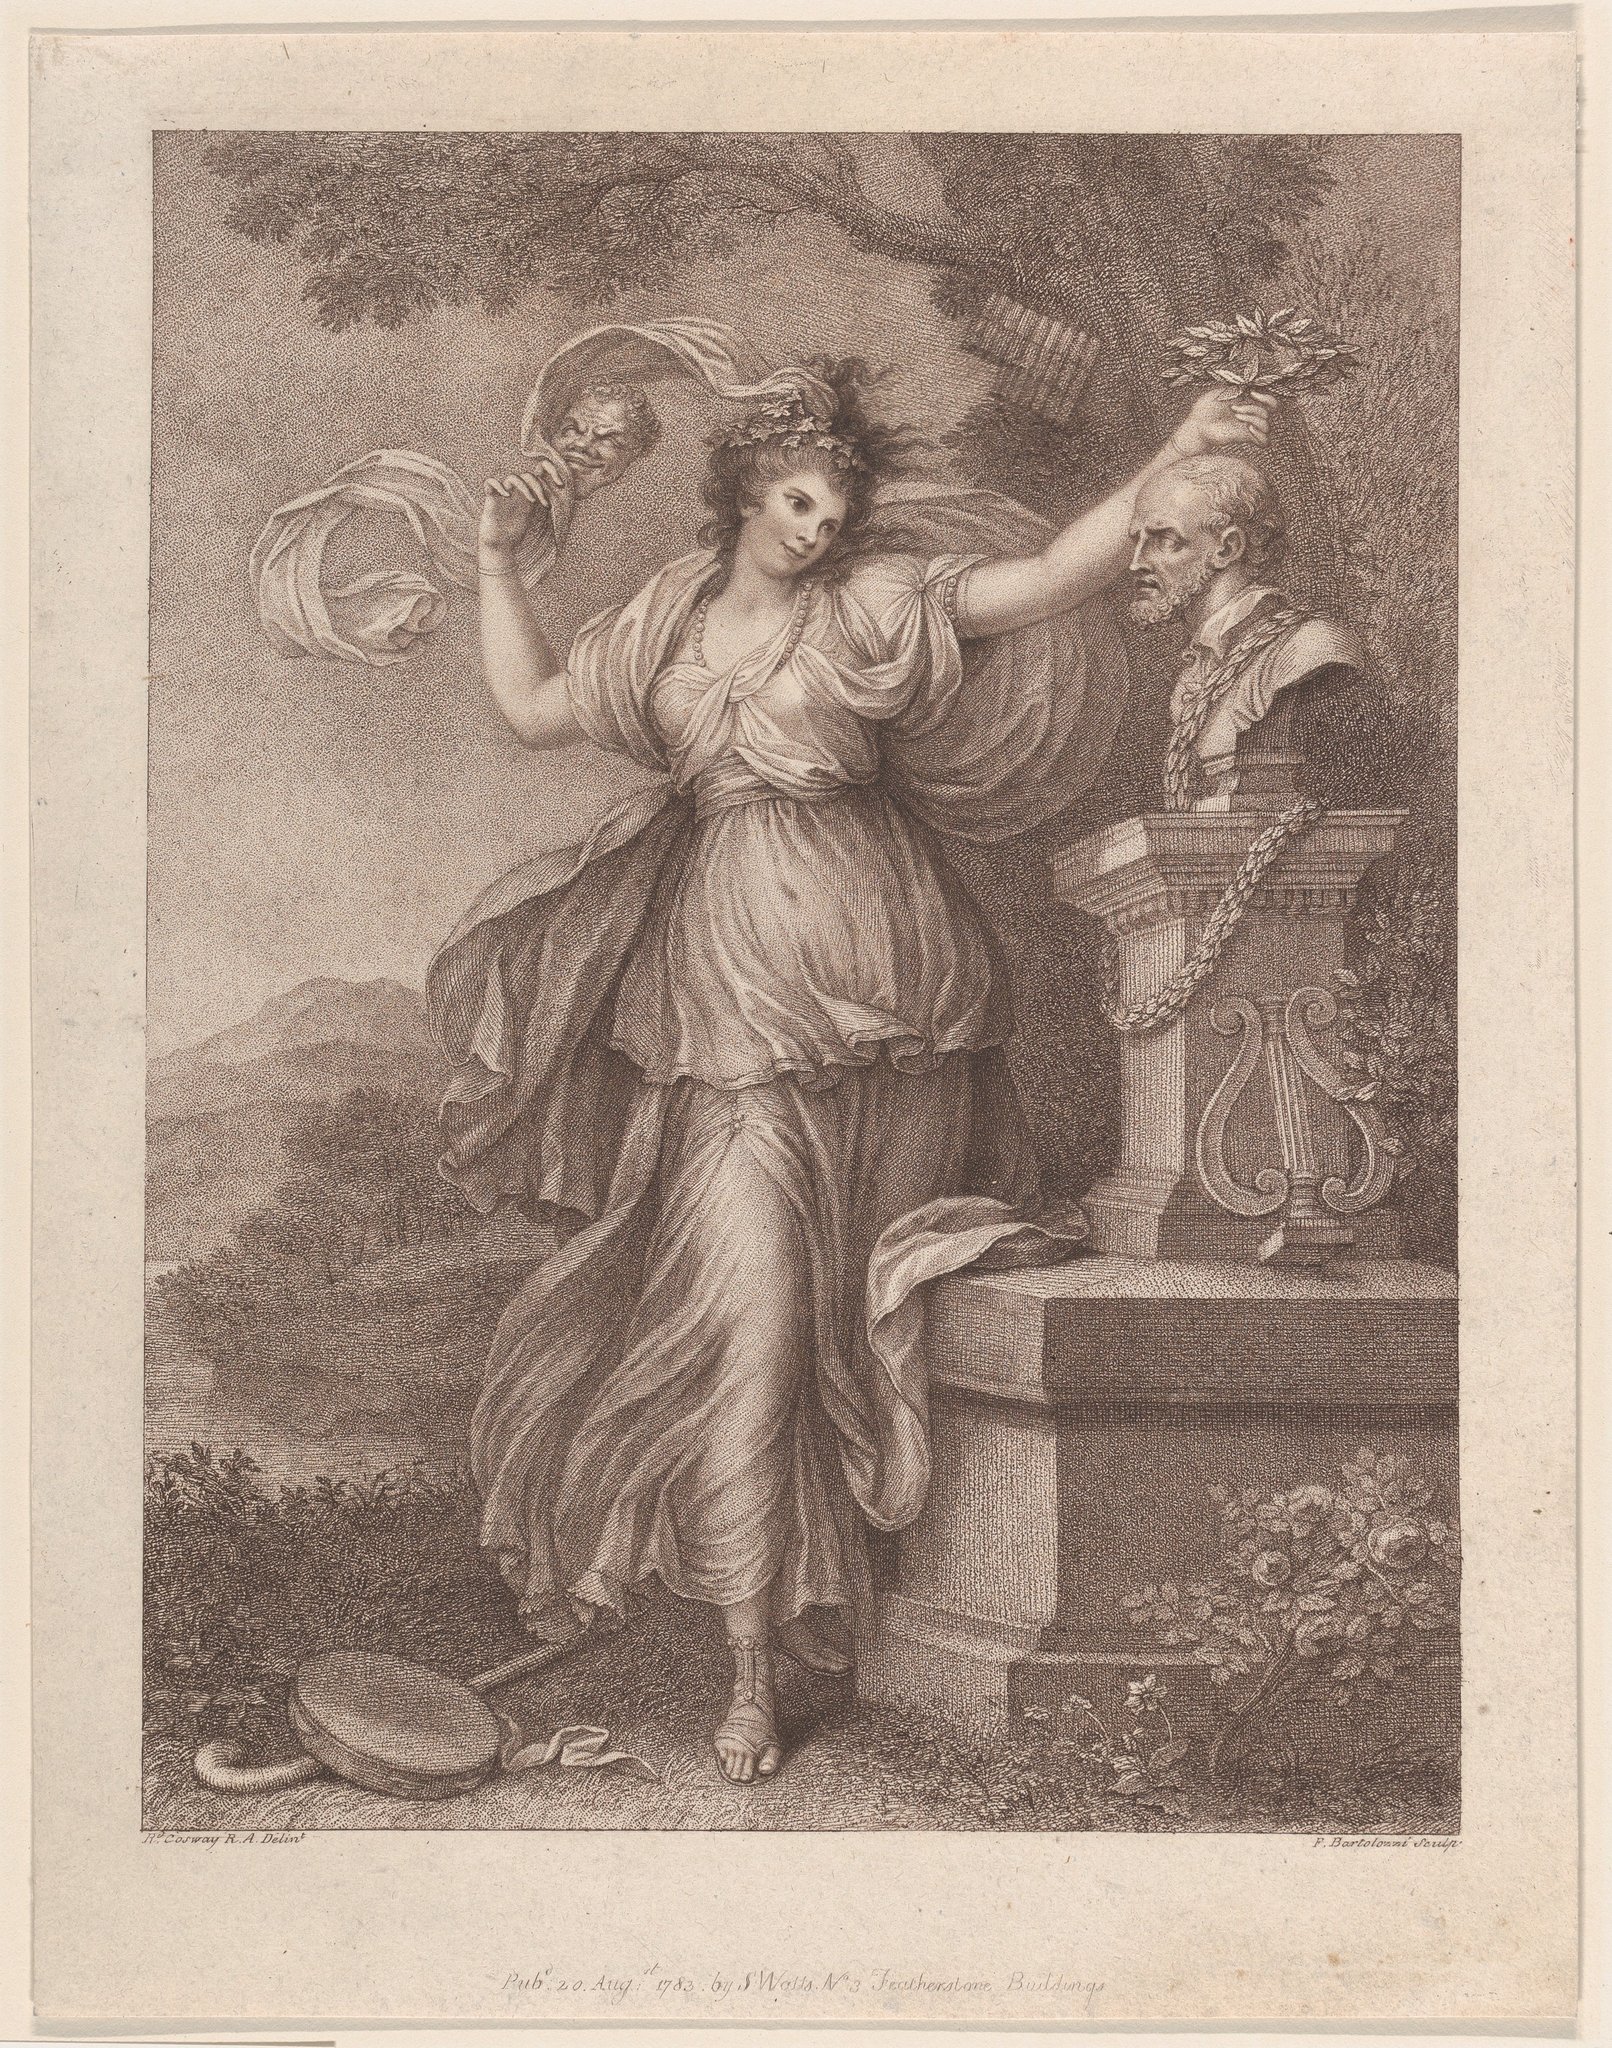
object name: print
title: Mrs. Abington as Thalia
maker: francesco bartolozzi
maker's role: artist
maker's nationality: italian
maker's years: 1728-1815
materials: ink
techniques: etching, printing, engraving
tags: masks,shakespeare,women,actresses